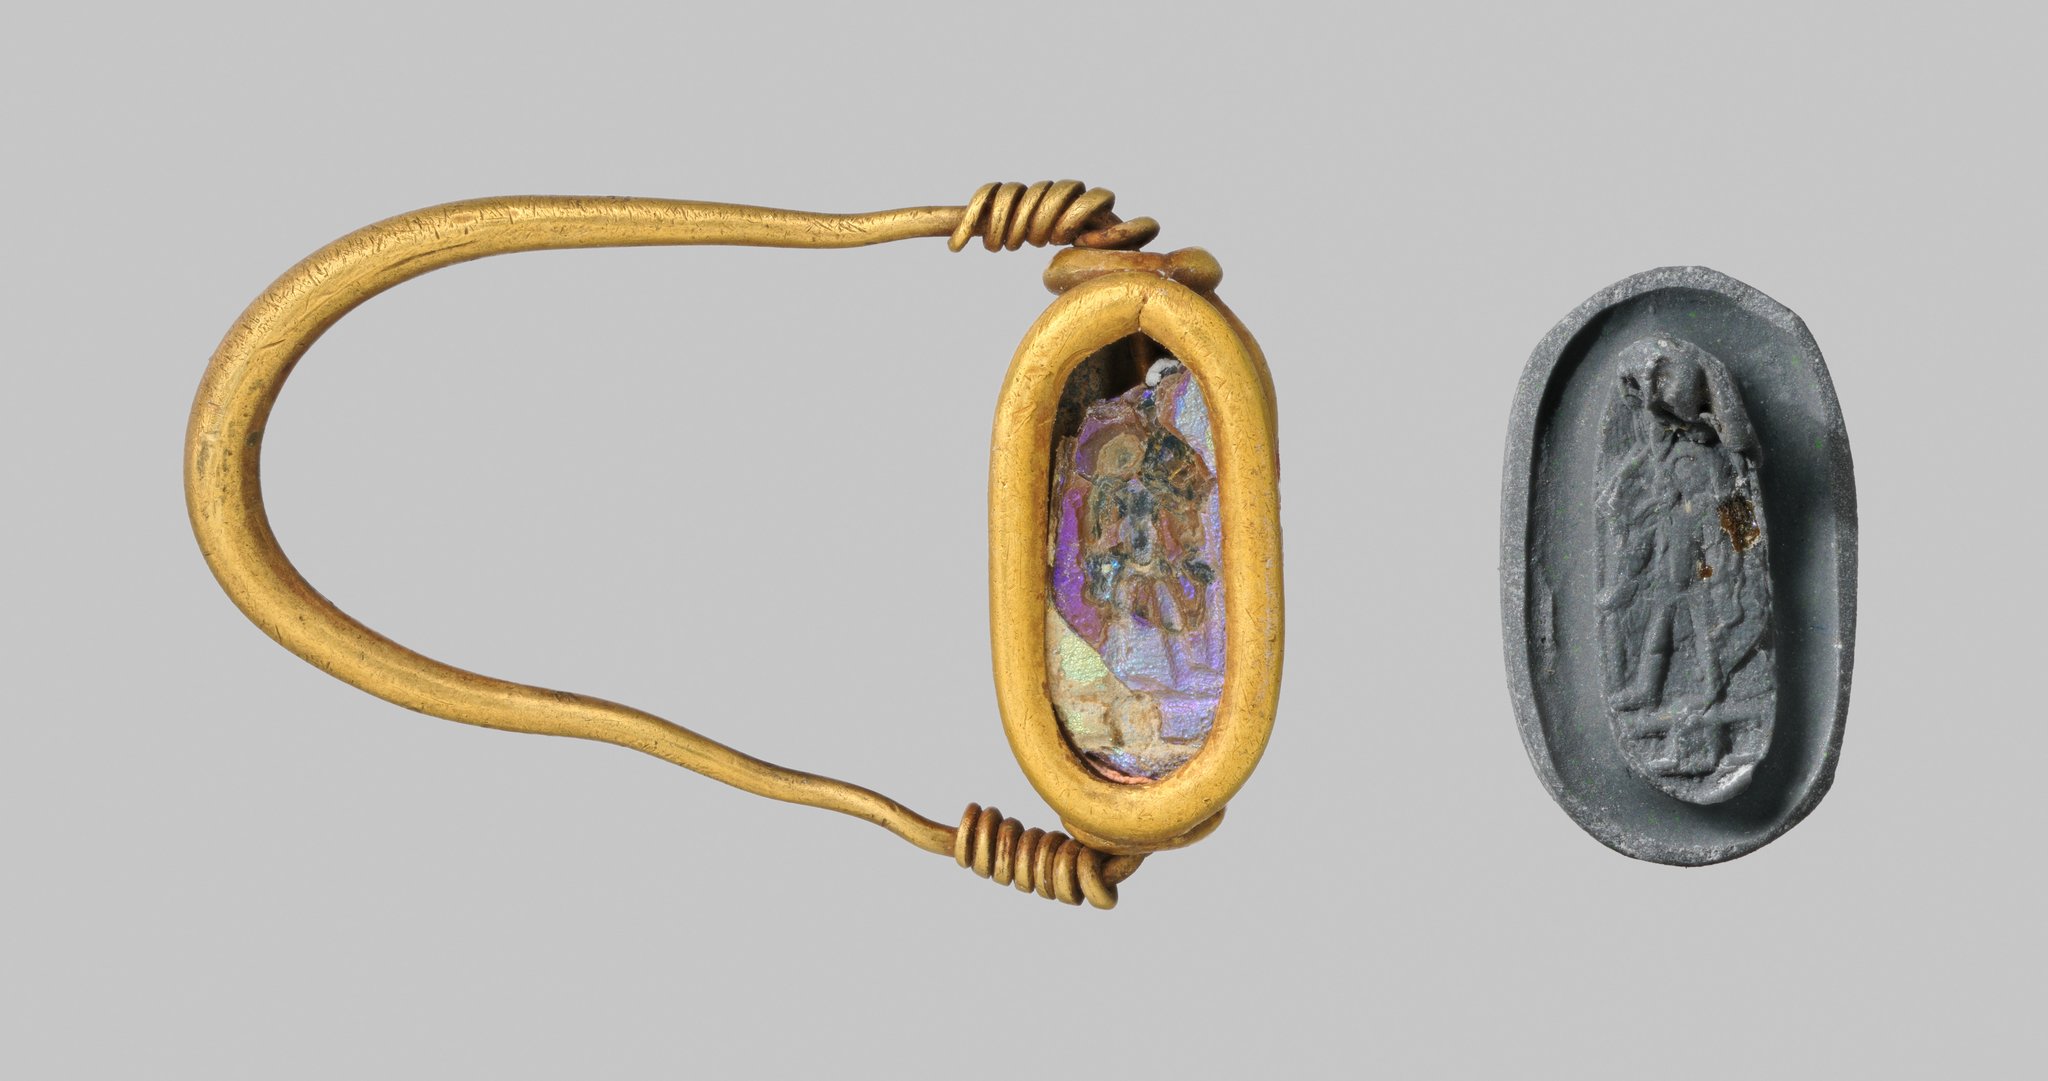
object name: ring with scarab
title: Gold ring with sphinx or lion-shaped scaraboid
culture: egyptian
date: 664-334 BCE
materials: glass, gold